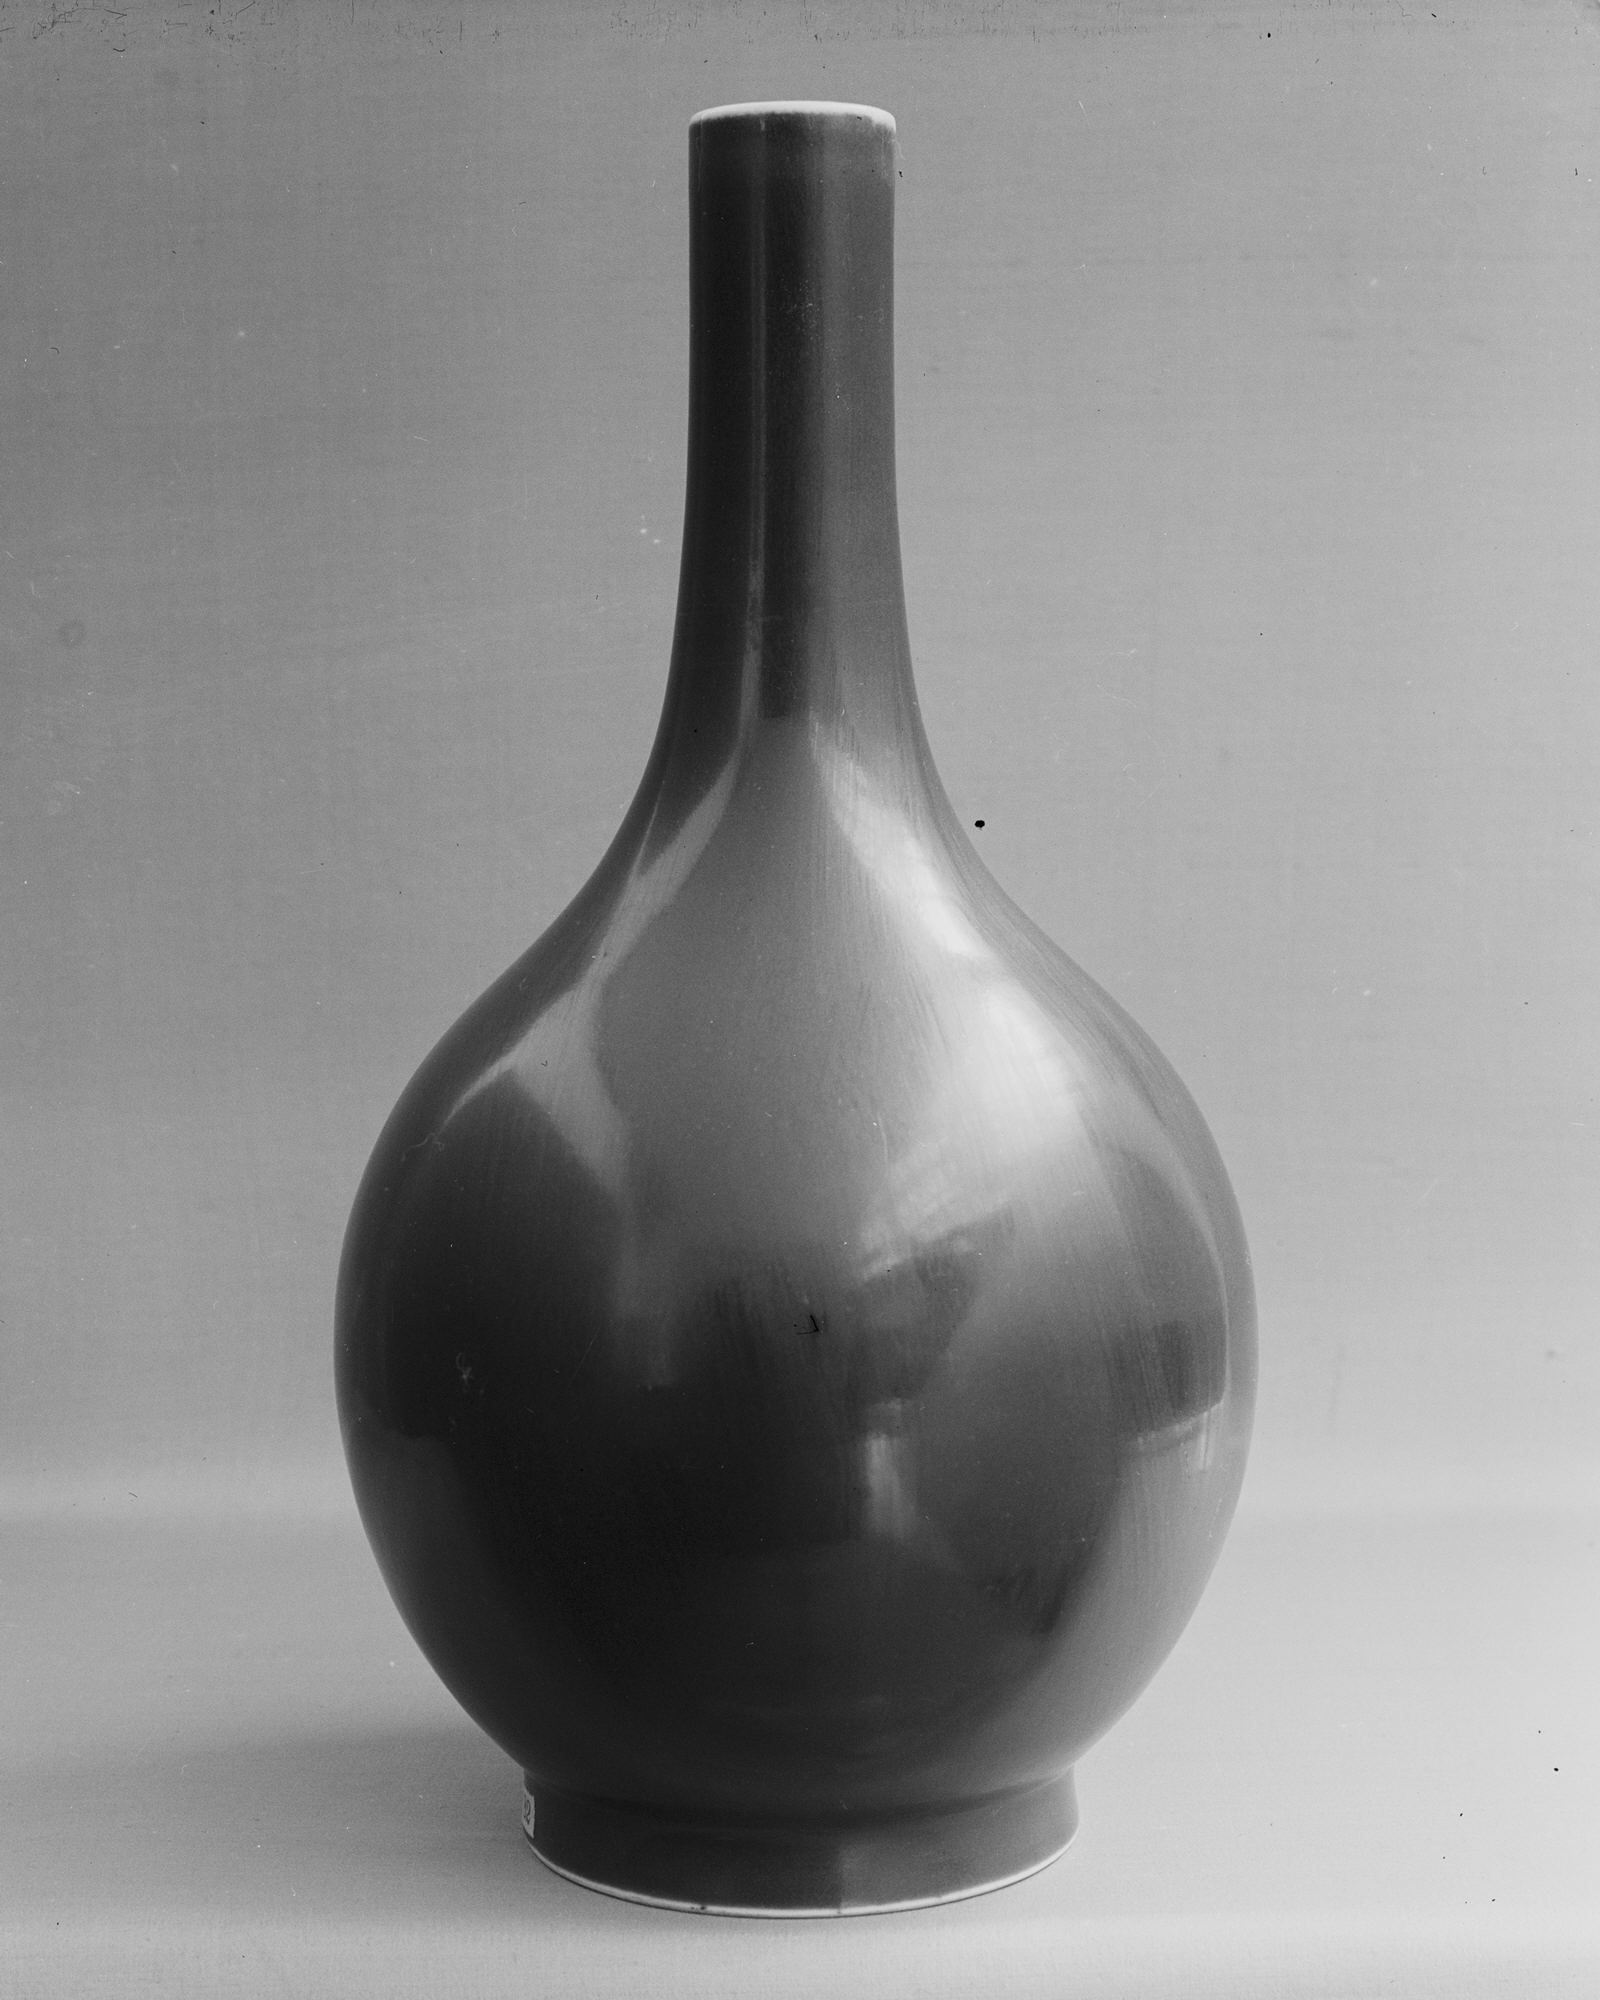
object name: bottle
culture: chinese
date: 1723-1735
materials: glaze, porcelain